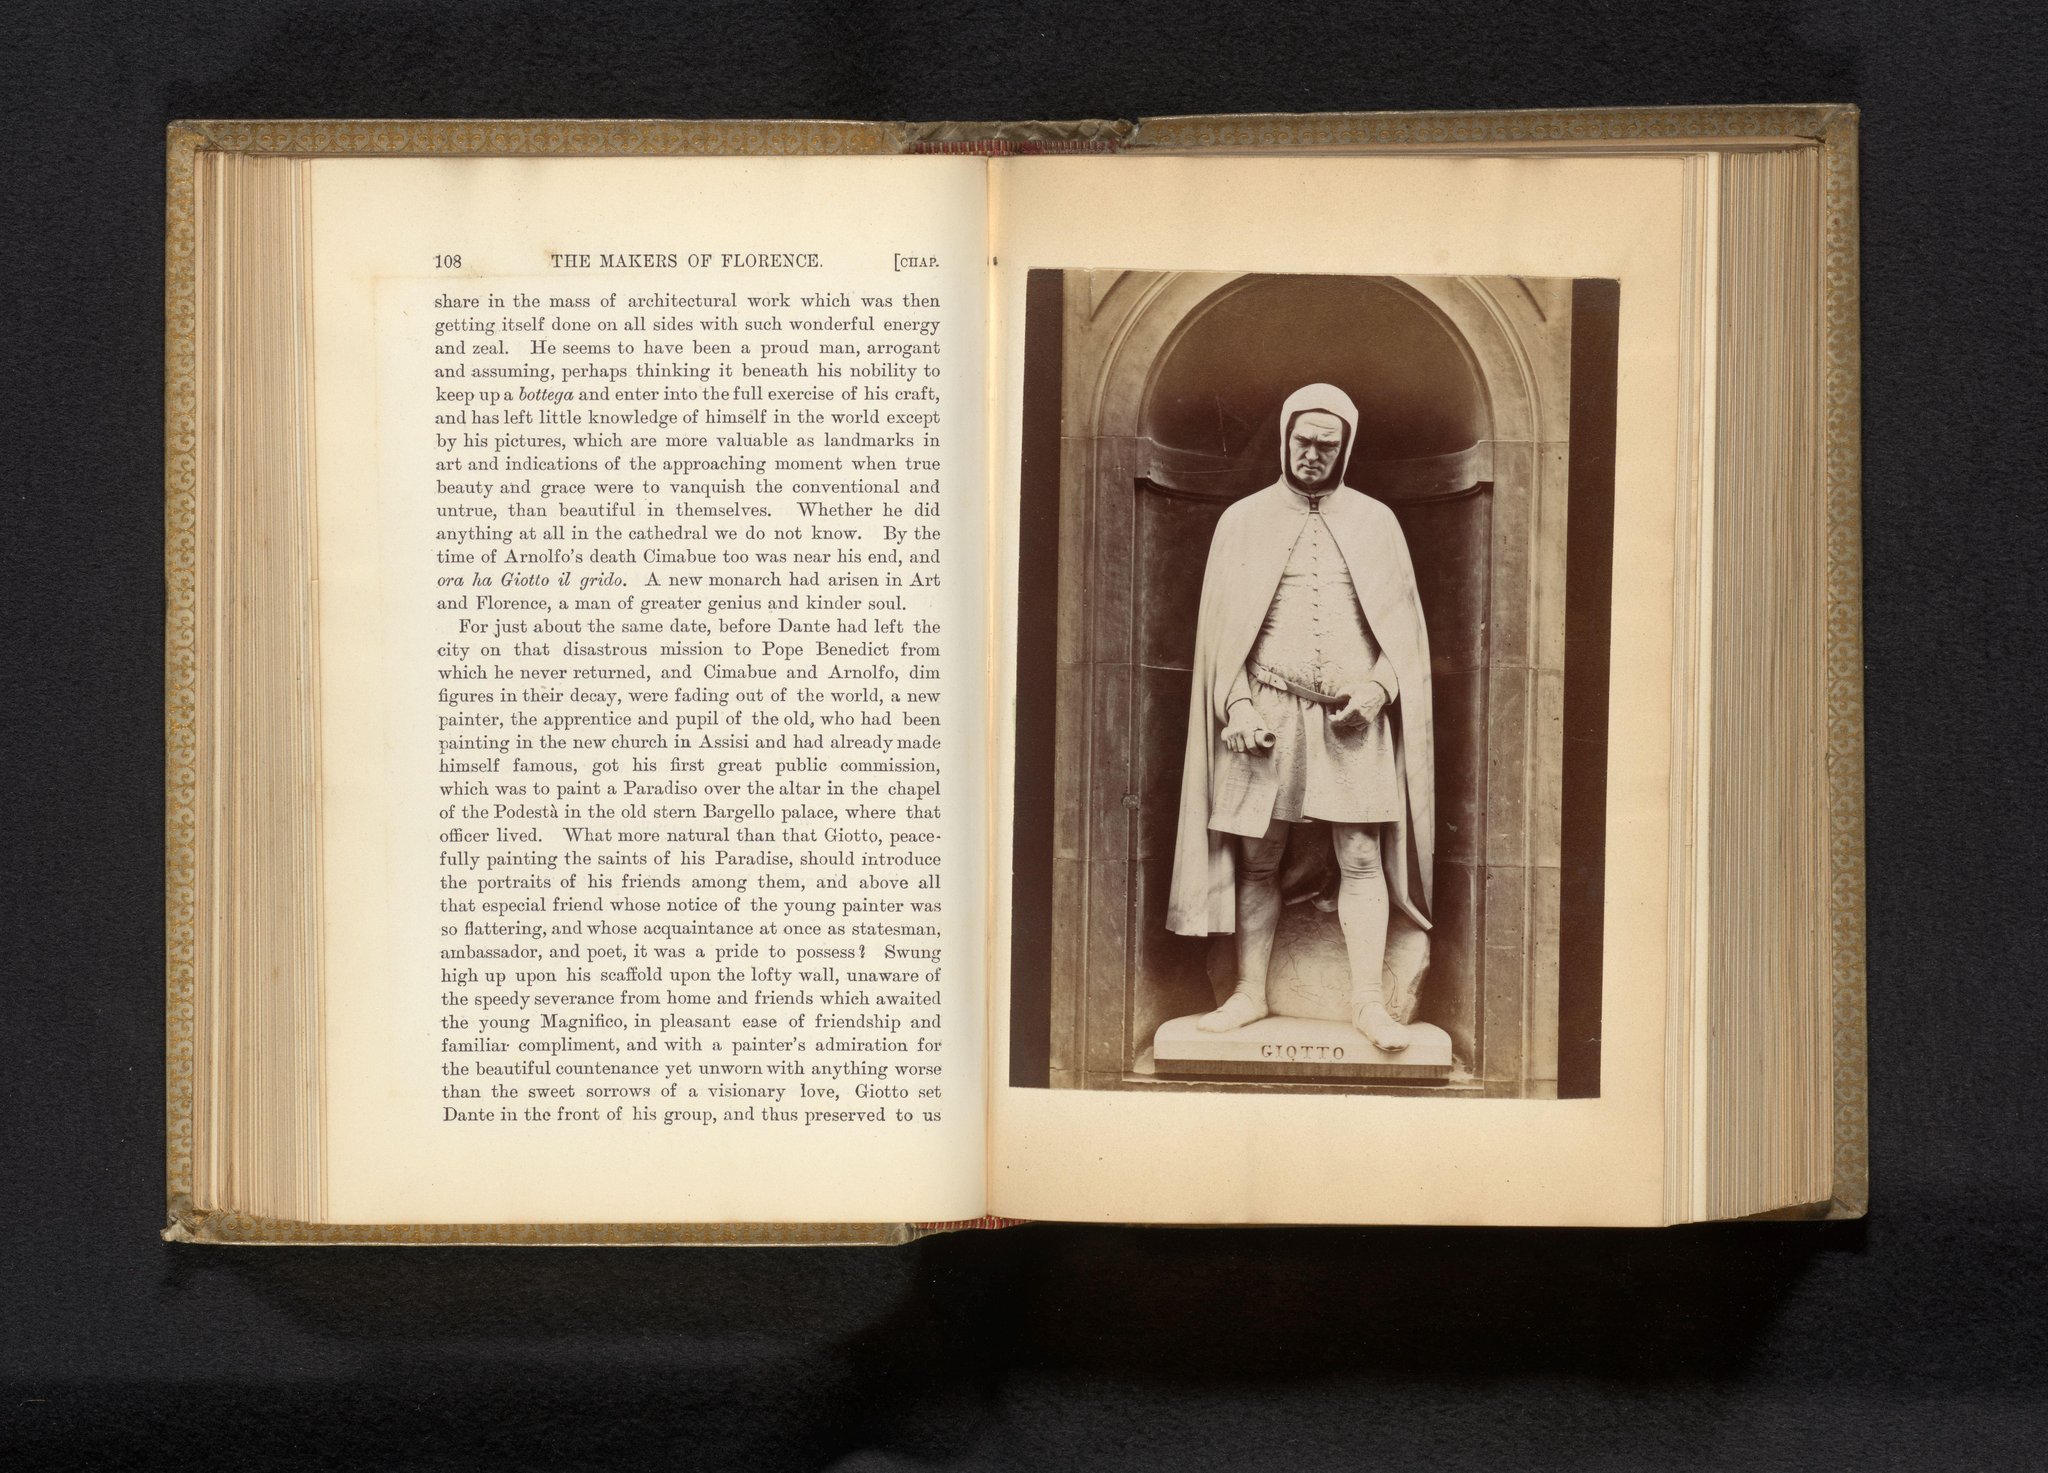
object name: photograph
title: Standbeeld van Giotto buiten de Galleria degli Uffizi te Florence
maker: Anonymous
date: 1878-1888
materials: photographic support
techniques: albumen print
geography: florence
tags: portrait, self-portrait of painter, sculpture, façade (of house or building)